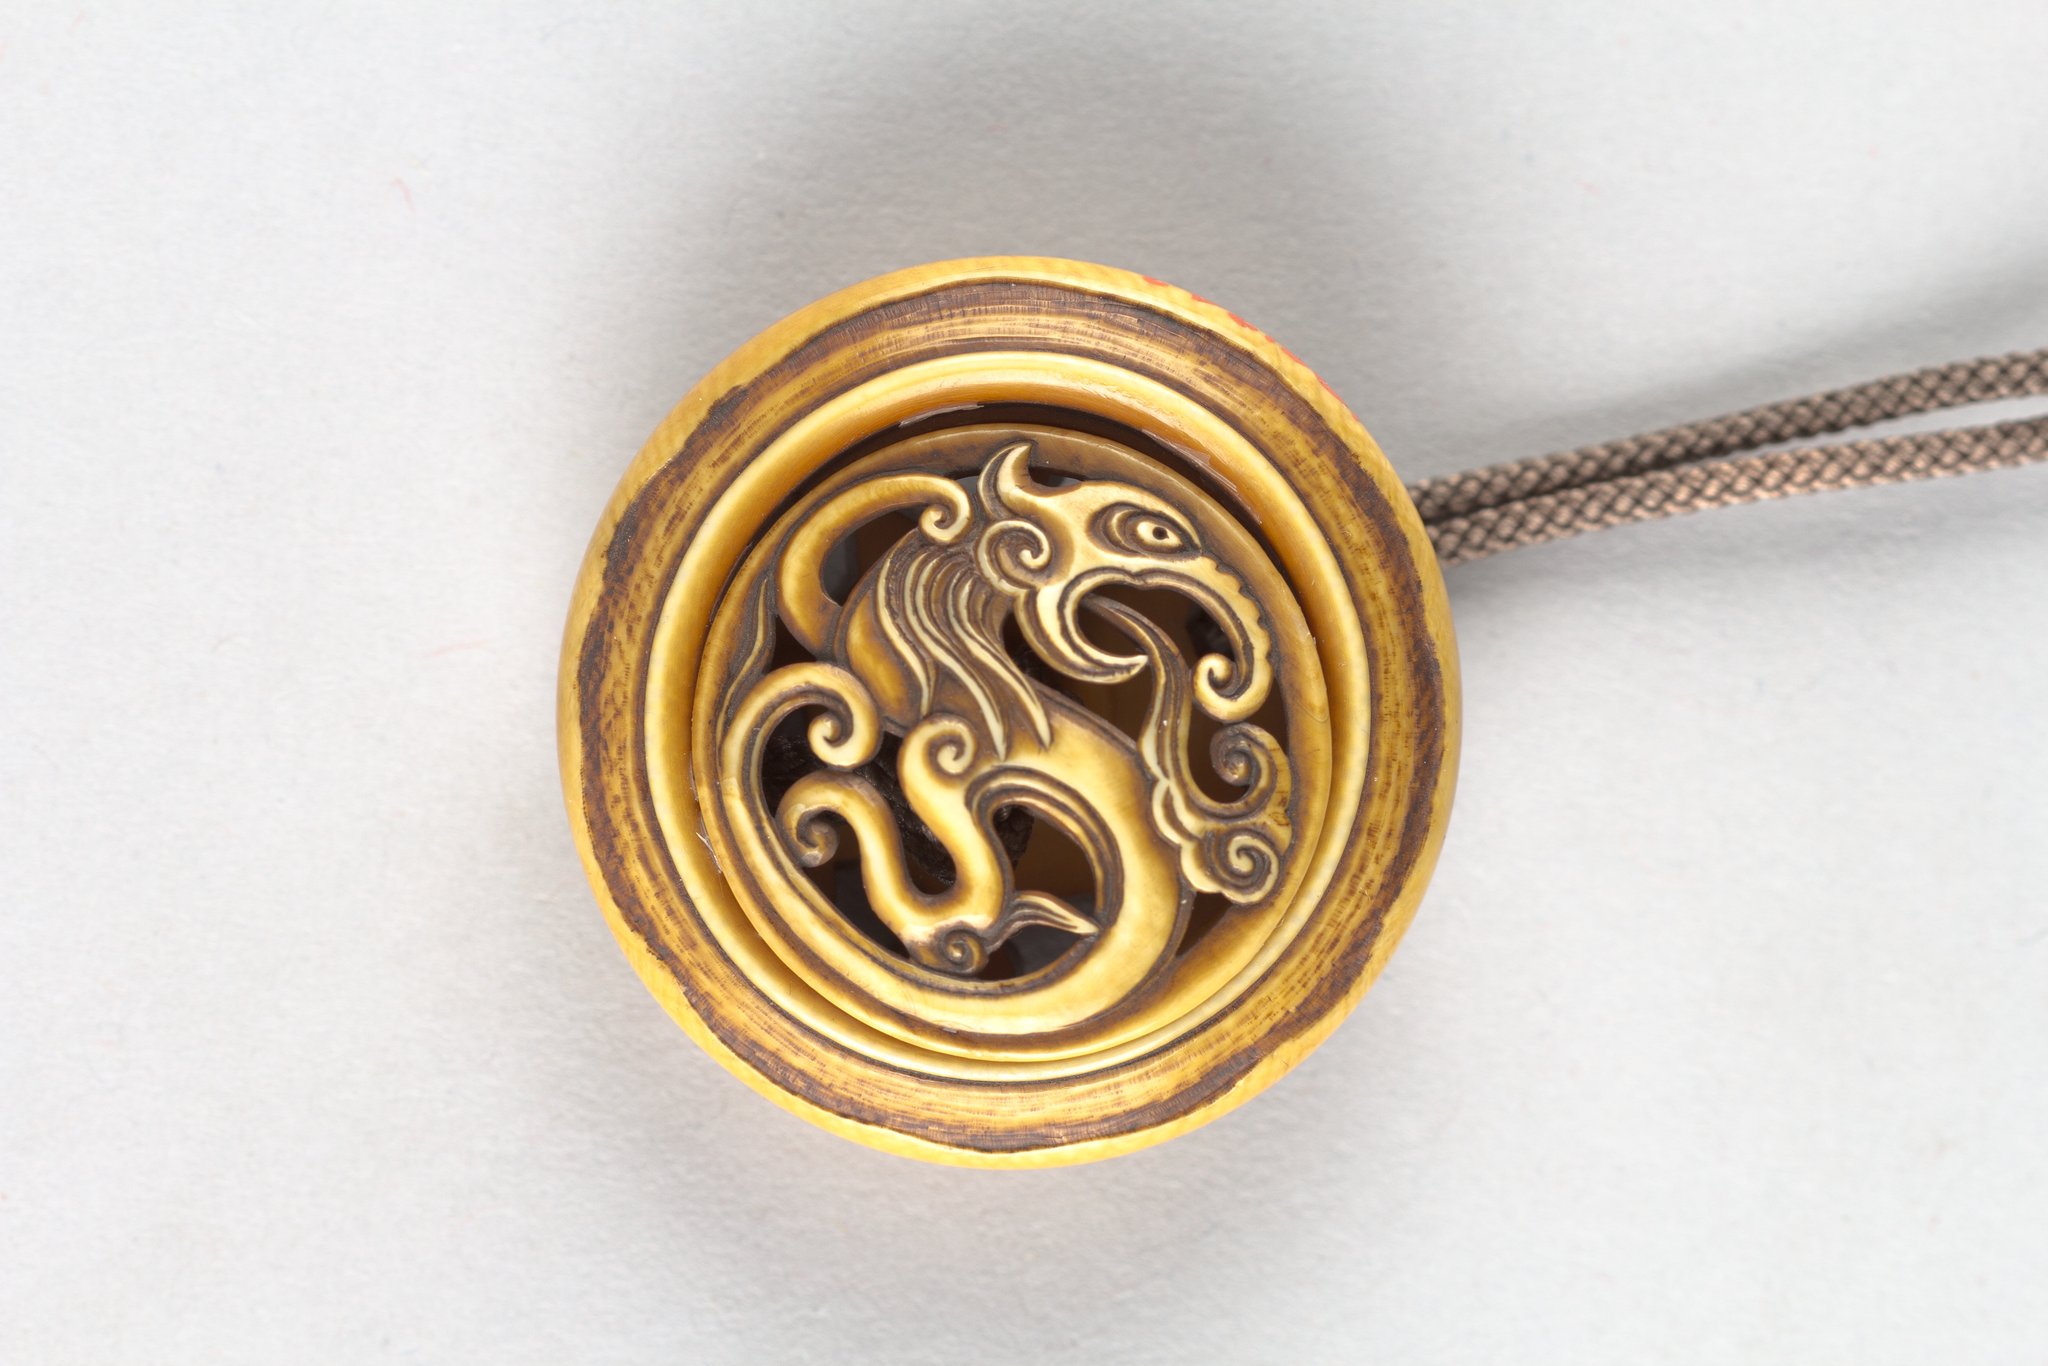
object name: netsuke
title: Netsuke with Kagamabuta-stylized Baku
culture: japanese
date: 1801-1900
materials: ivory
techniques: carving